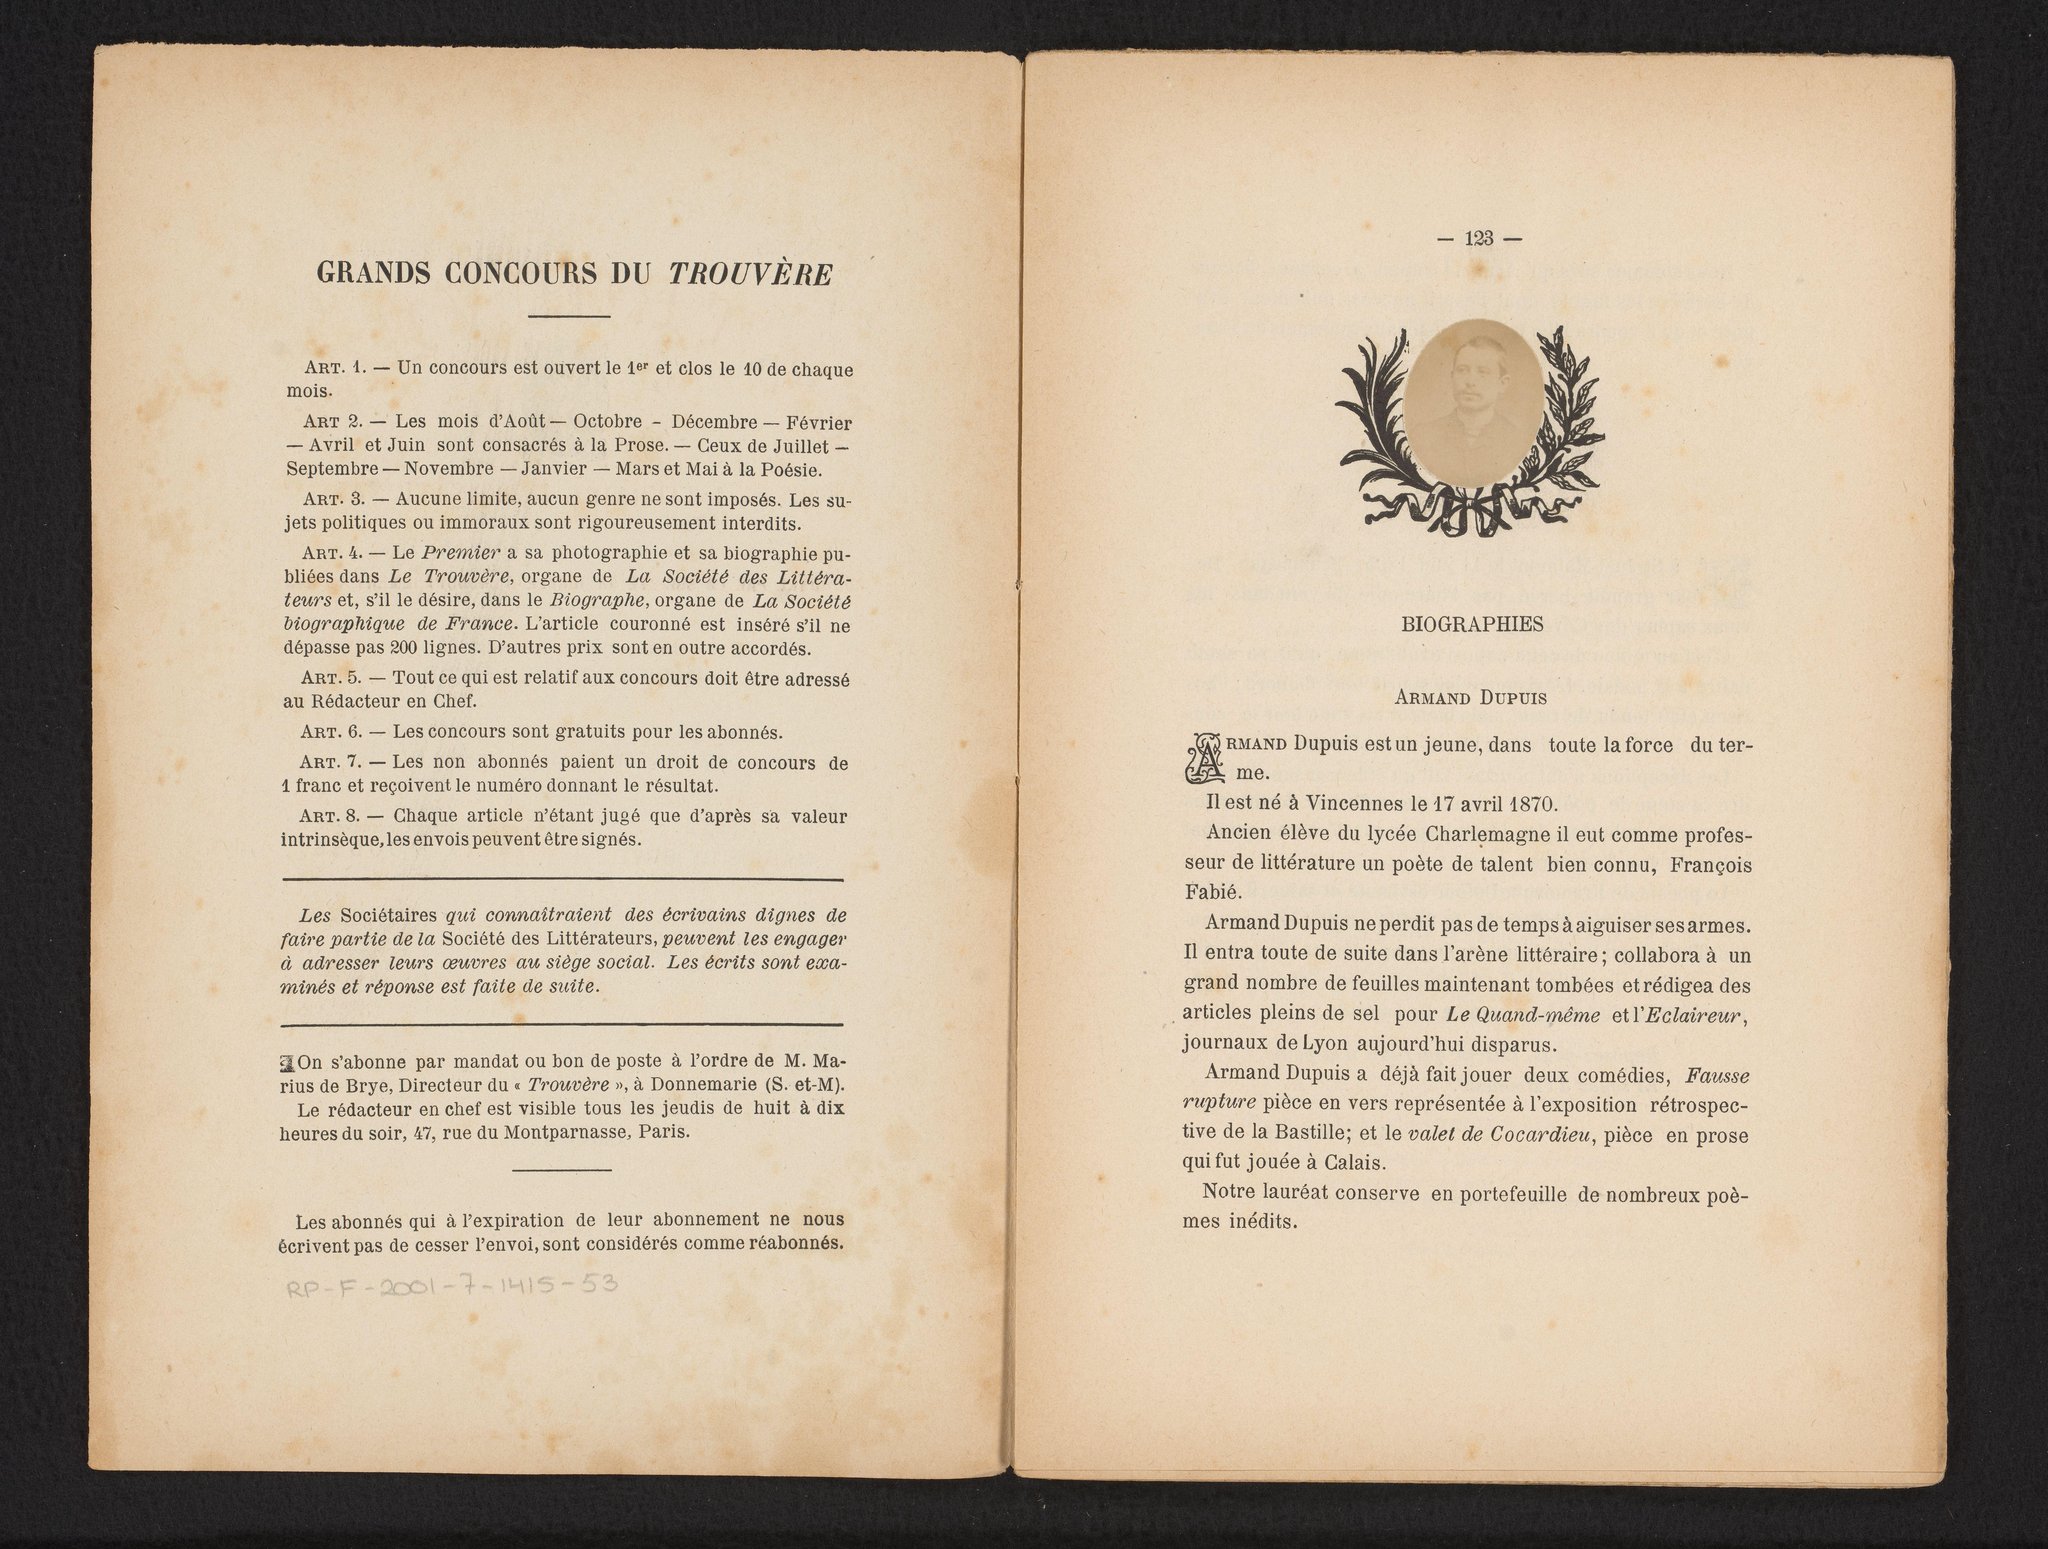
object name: photograph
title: Portret van Armand Dupuis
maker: Anonymous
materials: photographic support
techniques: albumen print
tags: historical persons